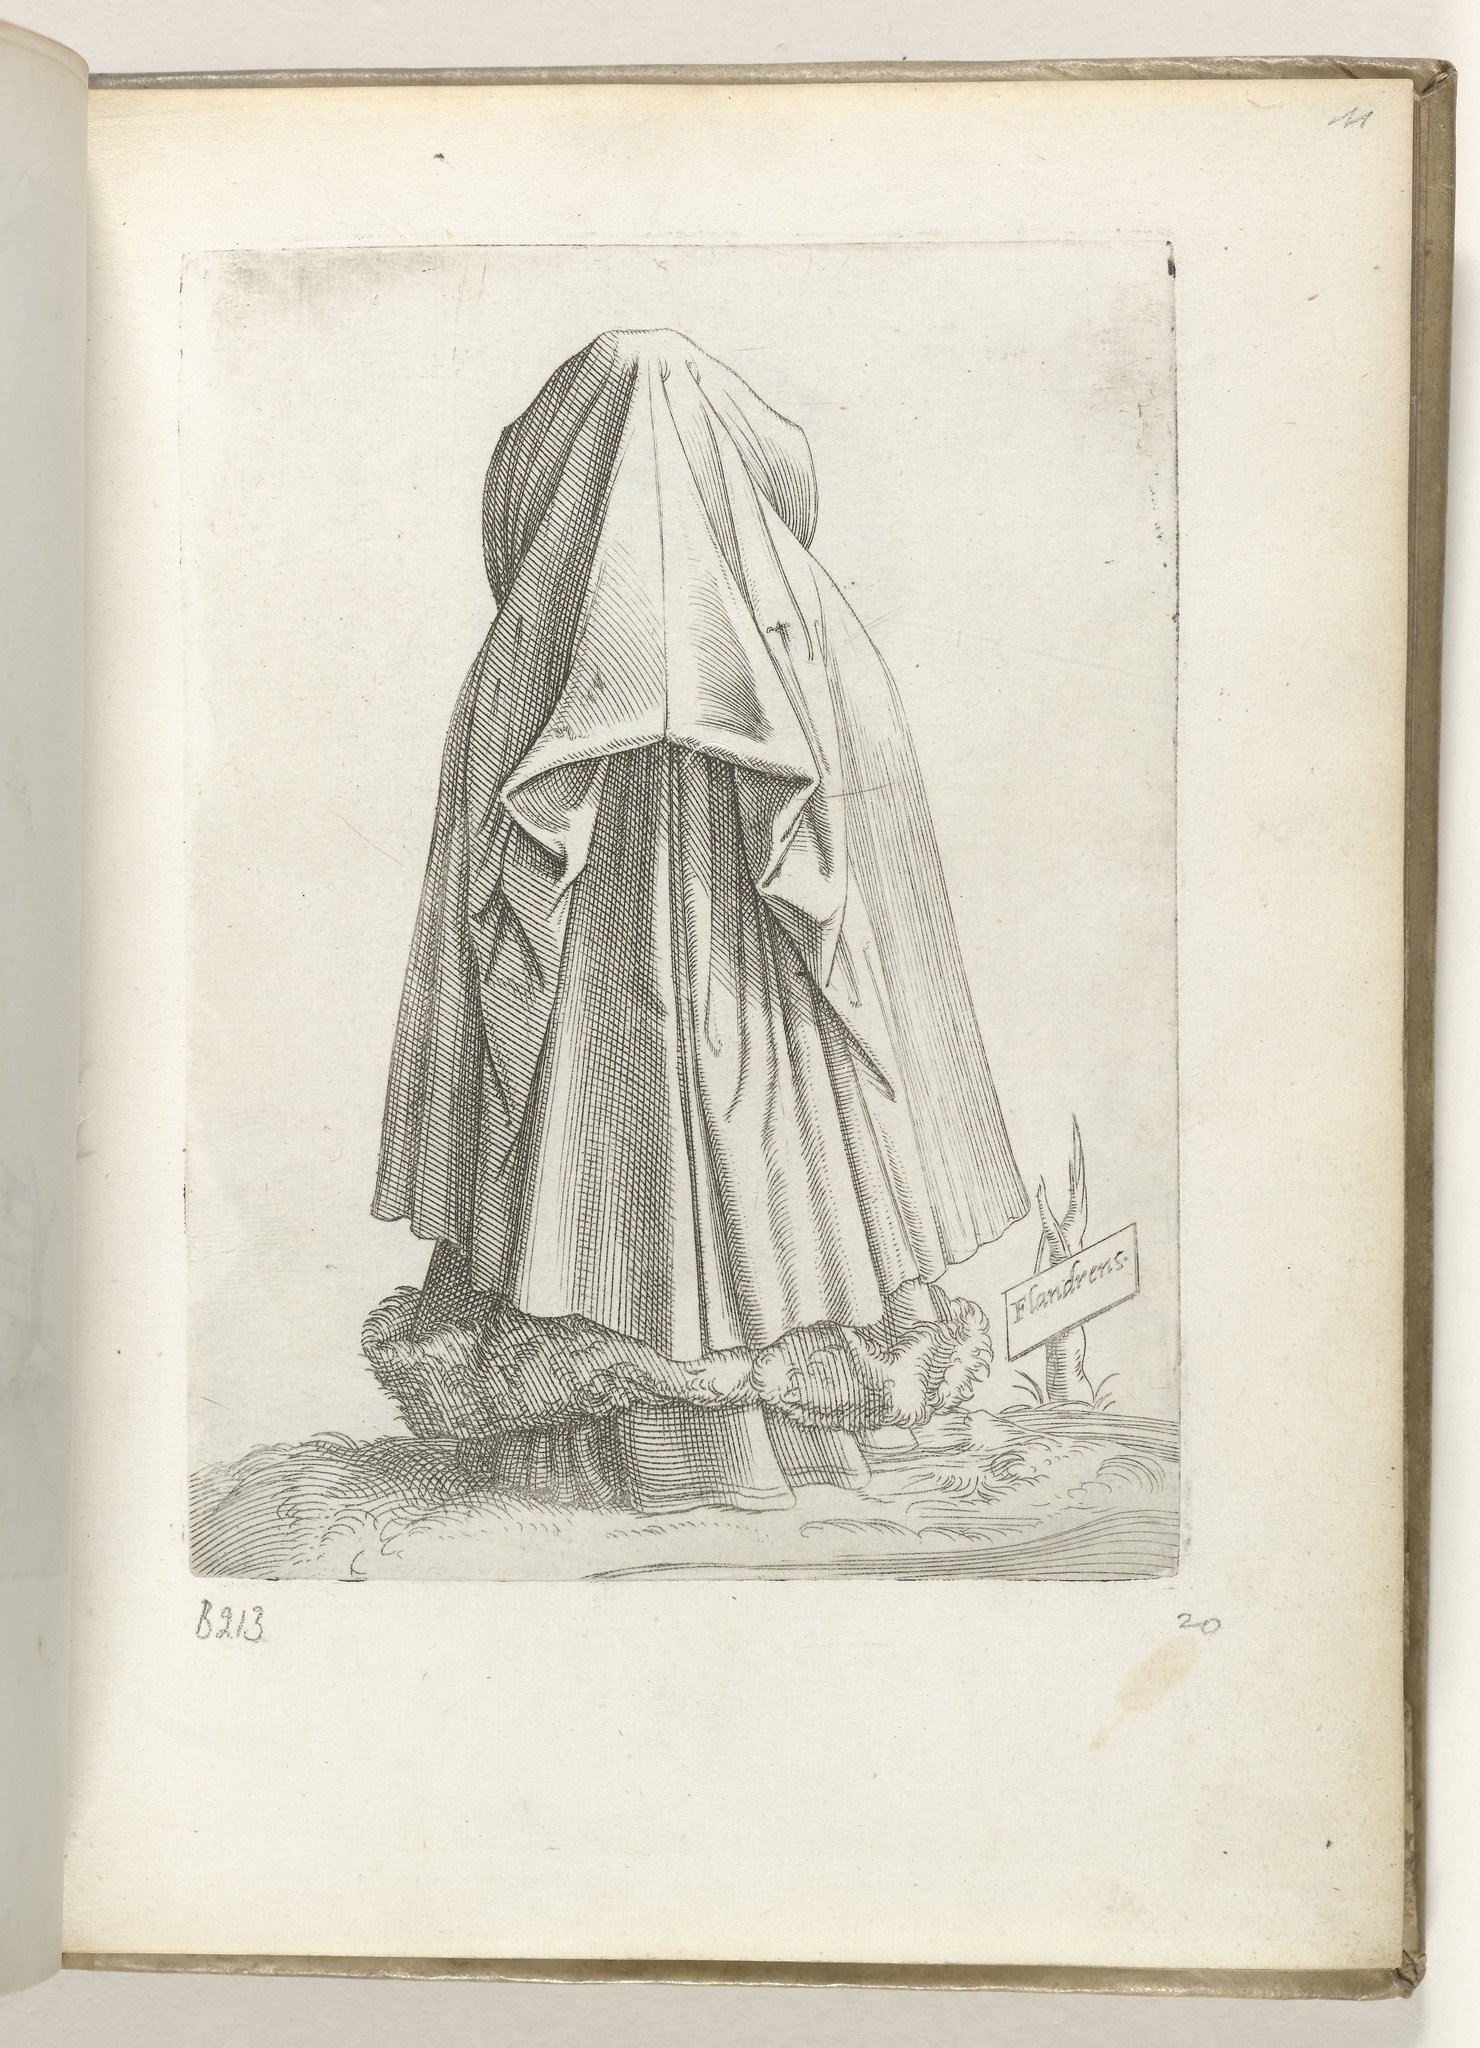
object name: costume print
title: Diversarum gentium nostrae aetatis habitus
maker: enea vico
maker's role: draughtsman, print maker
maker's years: 1523-1567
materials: paper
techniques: engraving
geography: venice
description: Vrouw op de rug gezien, gekleed in lang onderkleed met bontrand, waaroverheen mantel die over het hoofd naar beneden valt. Prent uit serie 'Diversarum gentium nostrae aetatis habitus'.